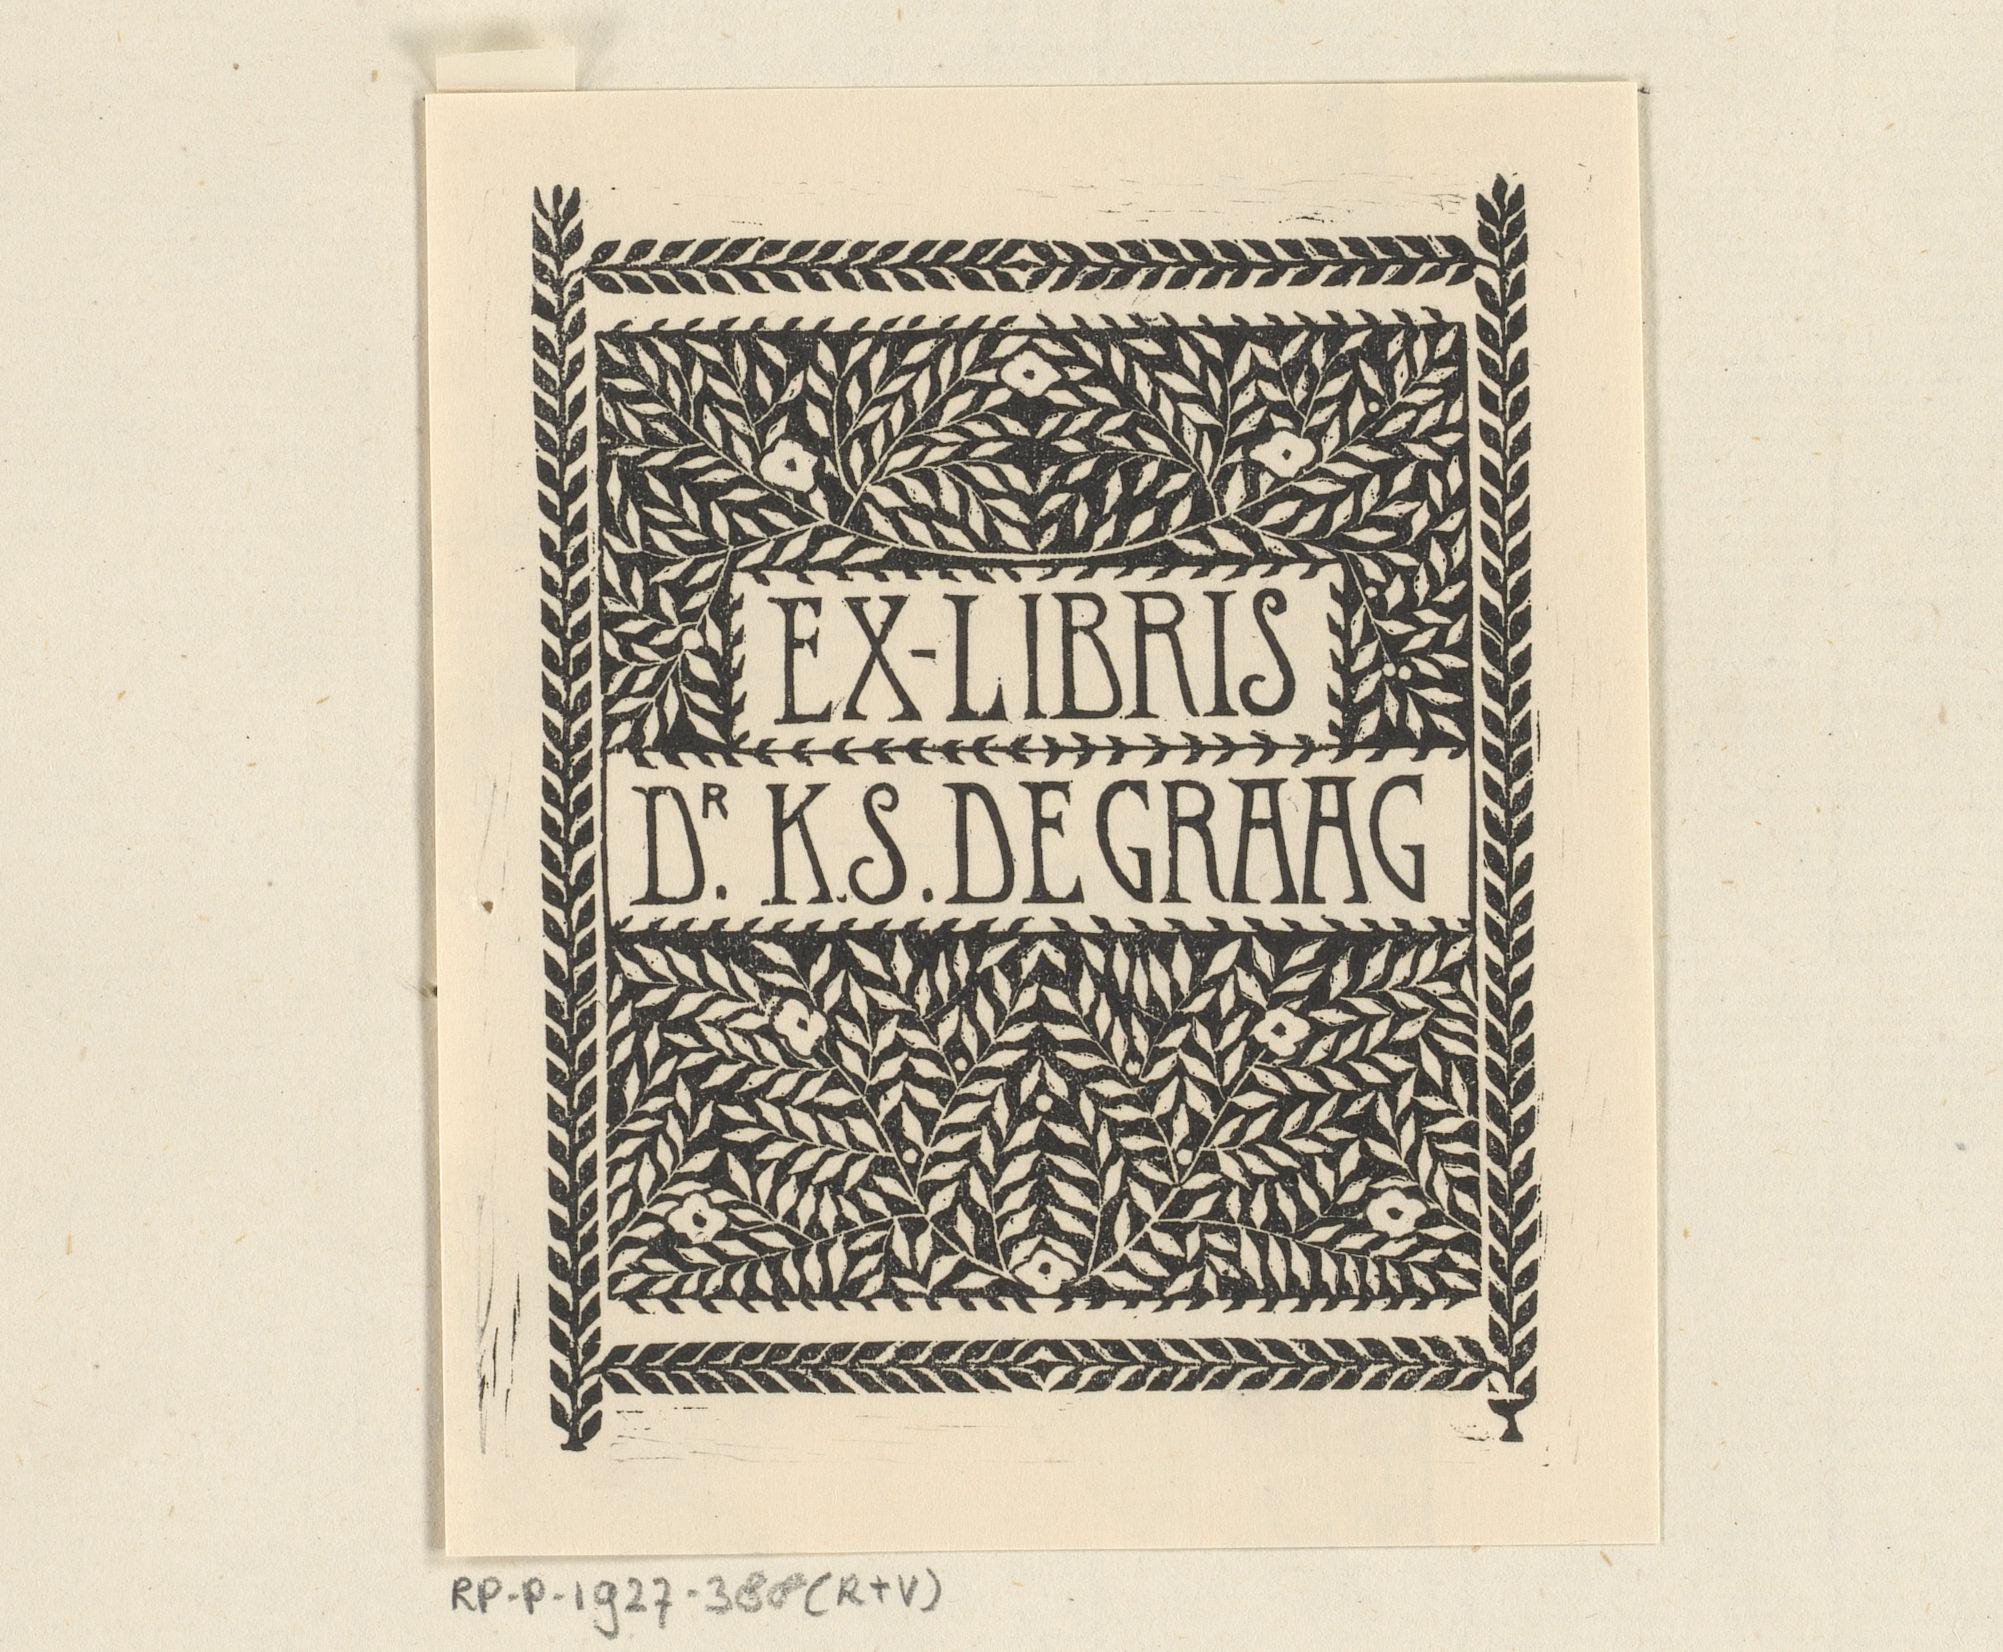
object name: bookplate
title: Ex libris van K.S. de Graag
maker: julie de graag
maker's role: draughtsman, print maker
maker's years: 1877-1924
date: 1878-1924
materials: paper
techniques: woodcut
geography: netherlands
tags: floral interlace ~ ornament